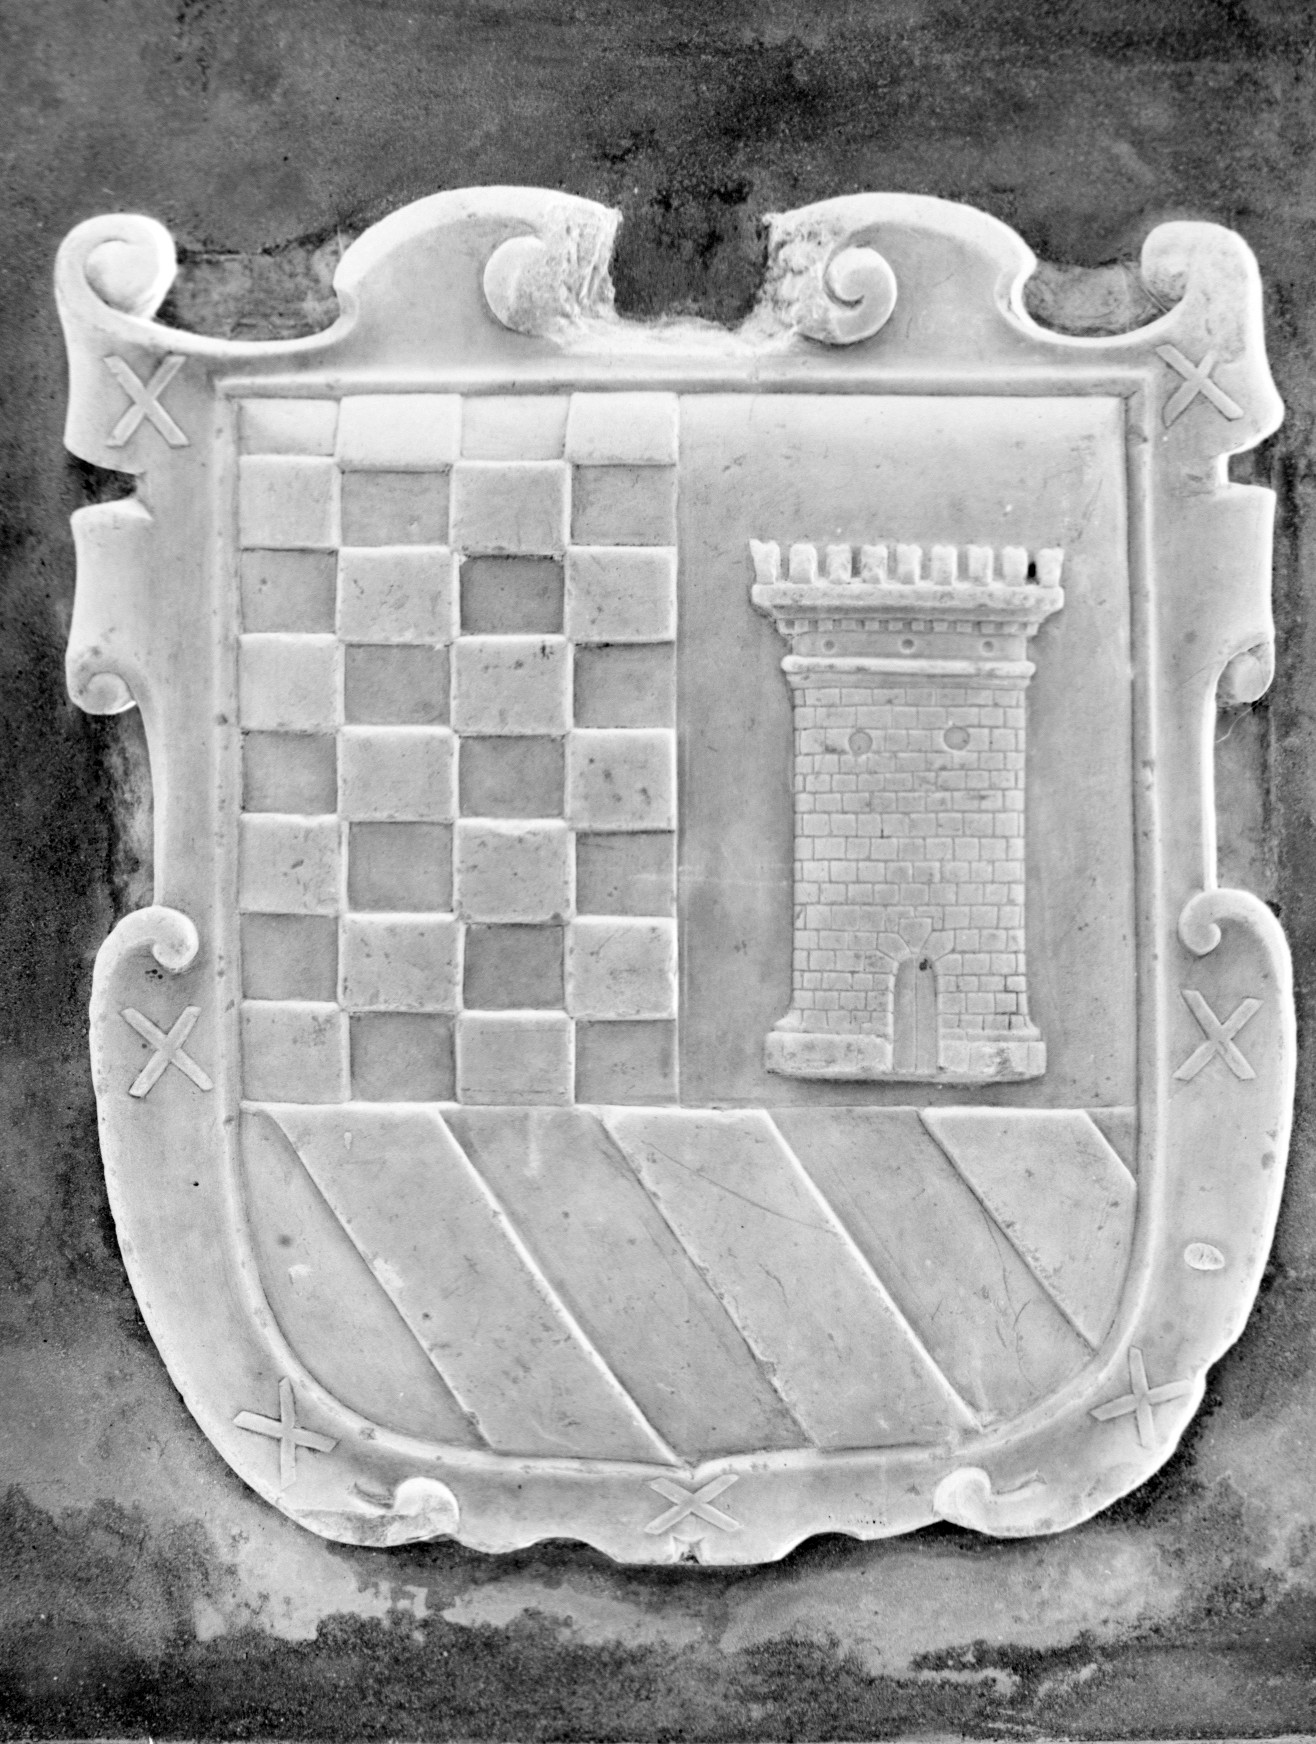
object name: armorial shield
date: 1501-1600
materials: stone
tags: shields